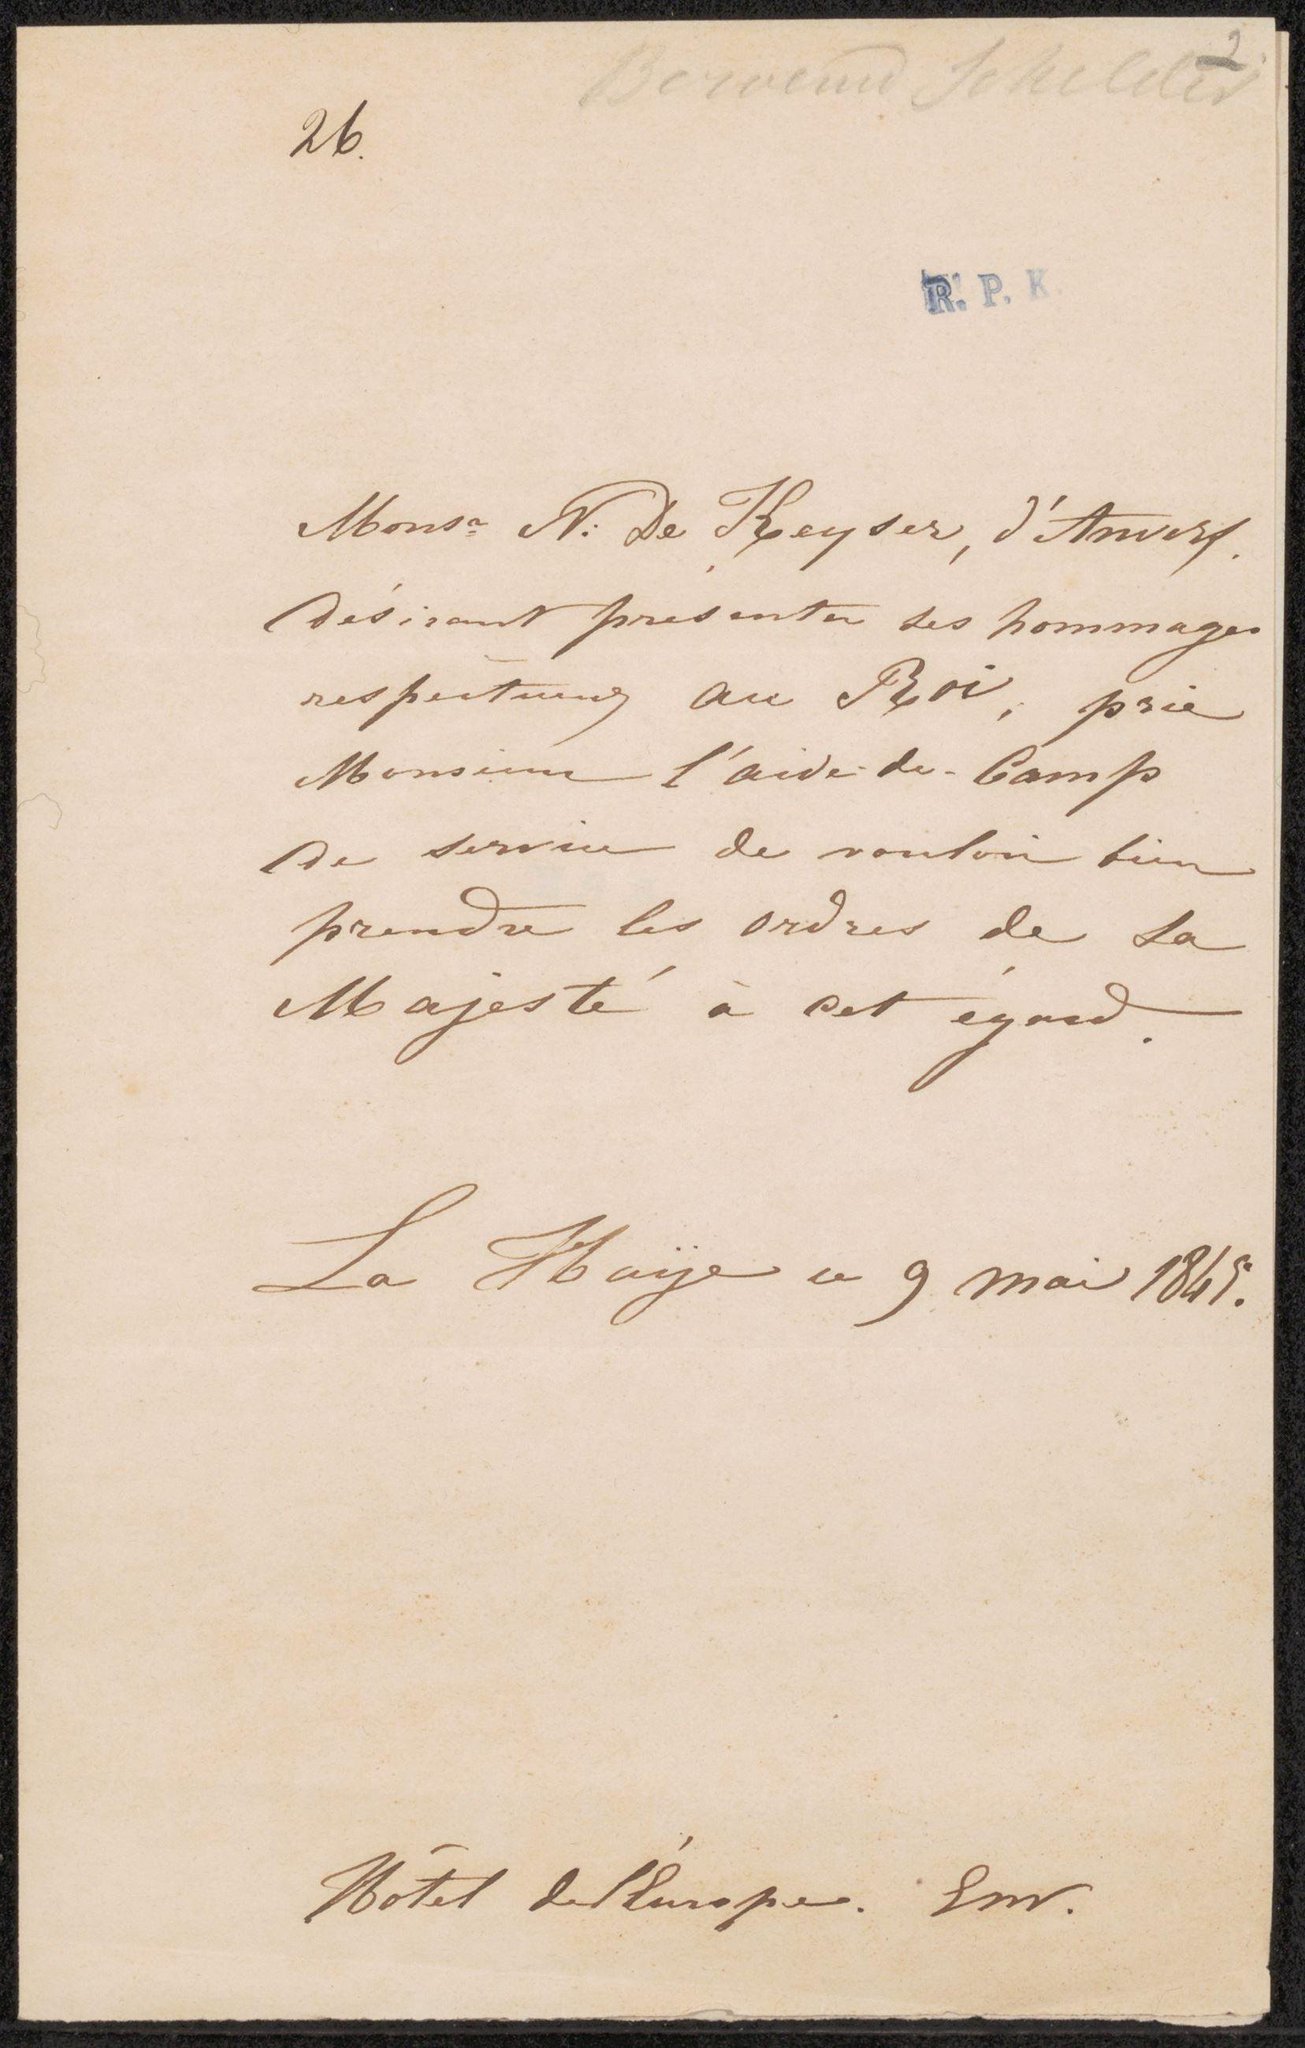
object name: letter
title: Brief aan de adjudant van Willem II (koning der Nederlanden)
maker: nicaise de keyser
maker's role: draughtsman, painter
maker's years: 1813-1887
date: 1845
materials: ink, paper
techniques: pen, writing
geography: the hague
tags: the hague, william ii of the netherlands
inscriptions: collector's mark: Lugt 2233